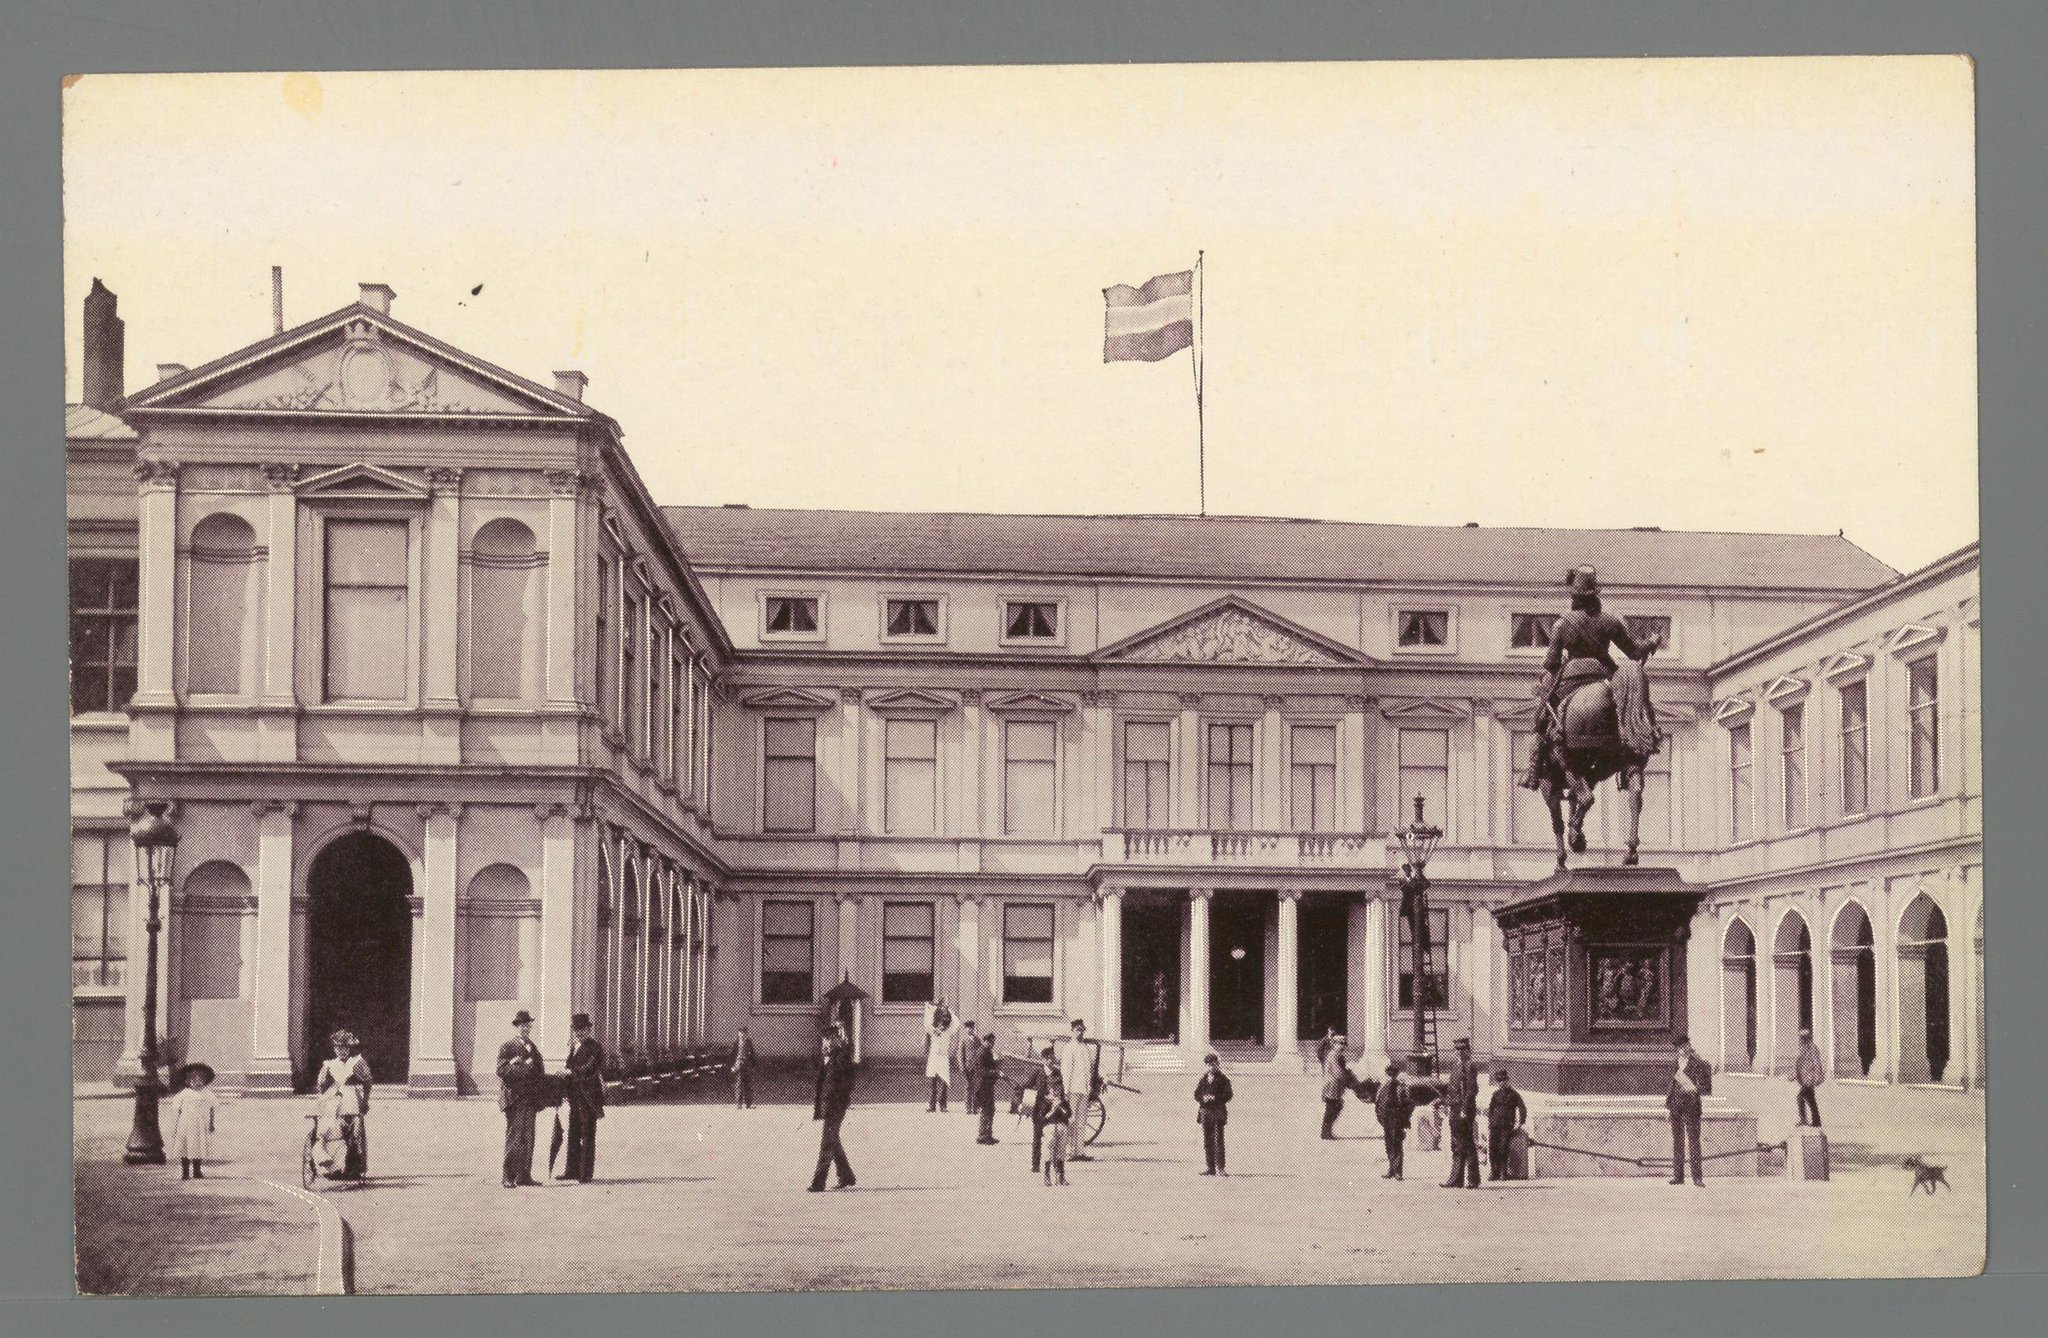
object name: photomechanical print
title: 's-Gravenhage. Het Koninklijk Paleis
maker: Anonymous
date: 1906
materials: cardboard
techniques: autotype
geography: the hague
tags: delft, william i (prince of orange), palace, monument, statue, flag, colours (as symbol of the state, etc.)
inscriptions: date